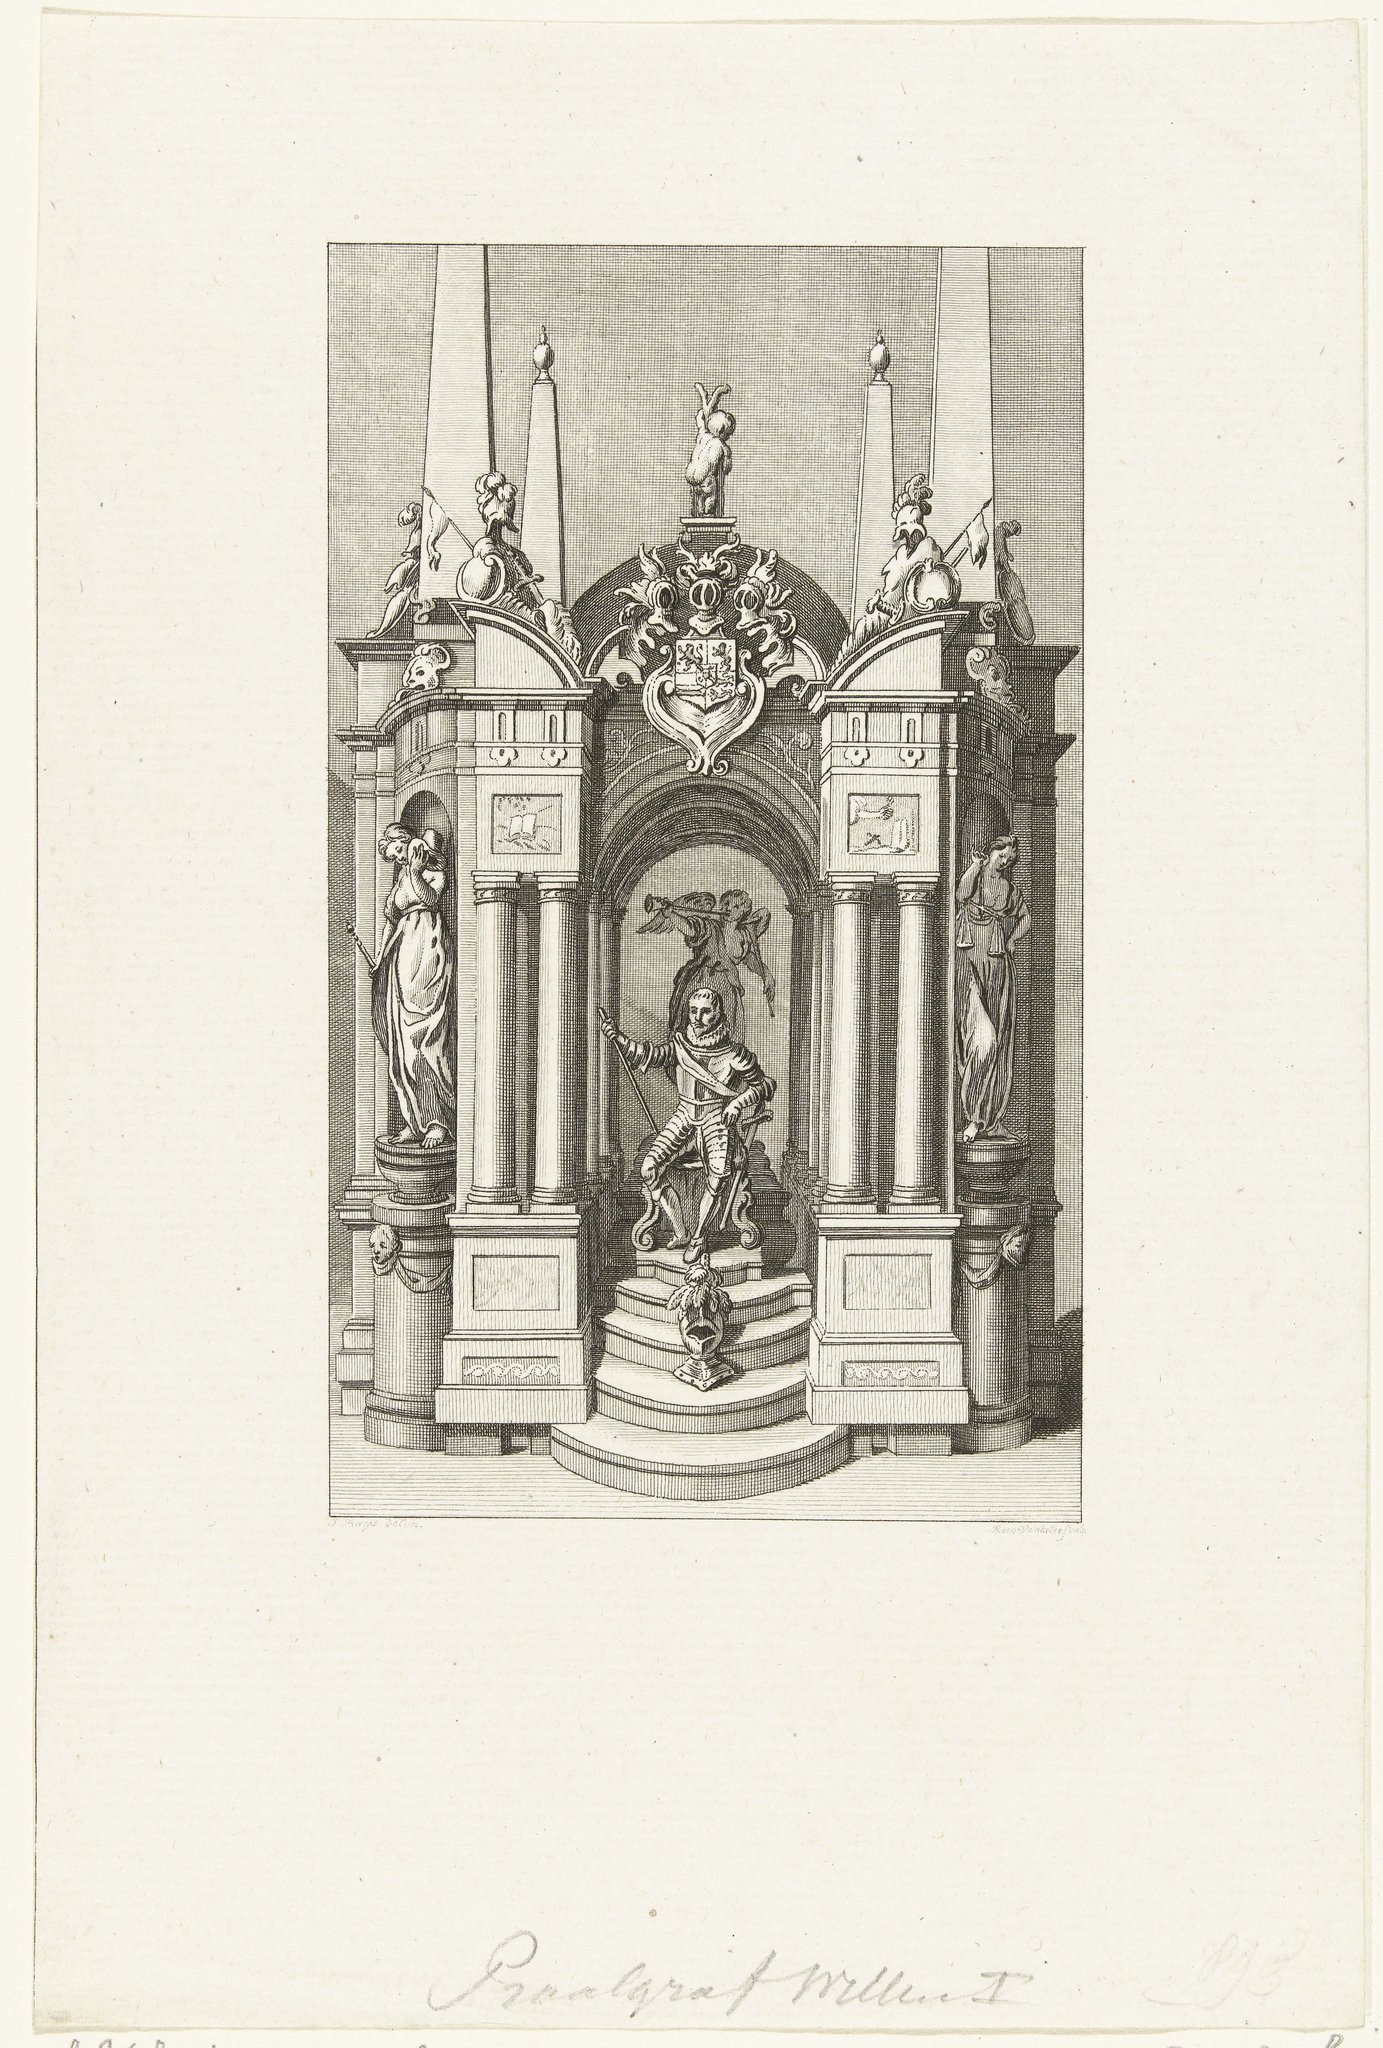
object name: print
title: Graftombe van Willem I, prins van Oranje, 1623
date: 1794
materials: paper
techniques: etching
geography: amsterdam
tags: william i (prince of orange), historical persons, interior of church, grave-building, monumental tomb, delft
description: De hier vermelde titel verwijst naar de hoogst verkregen titel van de geportretteerde, niet per se naar de titel die de geportretteerde op deze voorstelling draagt. Gebruikt als illustratie in: Jacobus Kok, Vaderlandsch Woordenboek, Johannes Allart, Amsterdam 1785-1799, 35 delen, dl. XXXI, pl. IV. Staat vóór de letter.